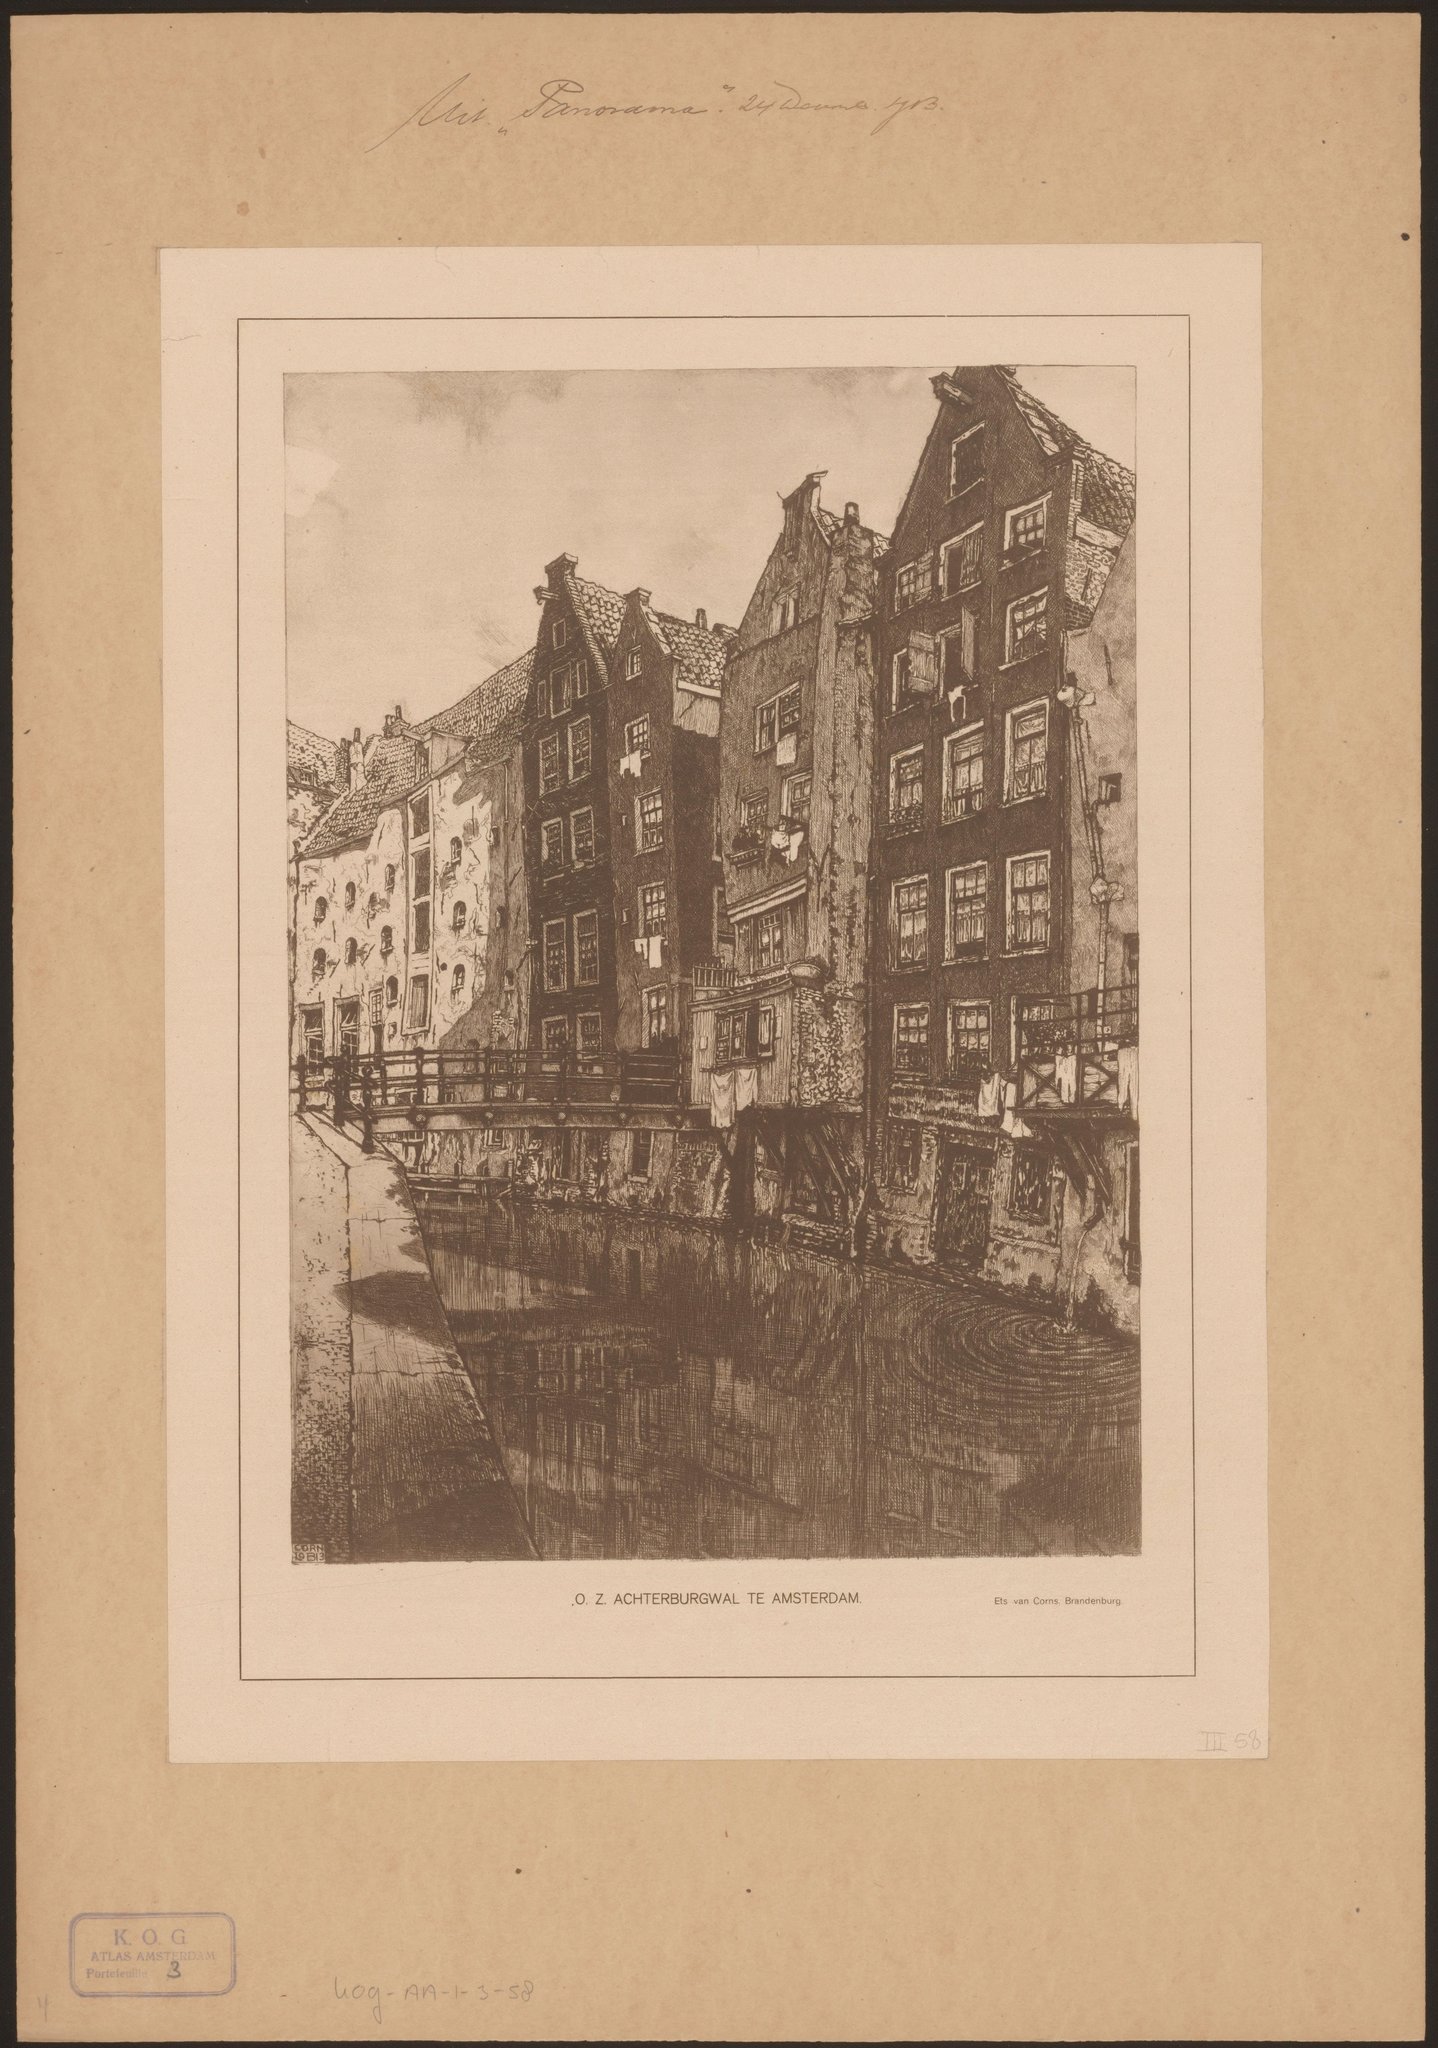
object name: photomechanical print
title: Gezicht op de Oudezijds Achterburgwal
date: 1913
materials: paper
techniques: letterpress printing, rotogravure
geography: amsterdam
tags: city-view in general; 'veduta', canal, the usual house or row of houses, bridge in city across river, canal, etc.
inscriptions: collector's mark: ‘3’ Lugt 1641b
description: Onderwerpsrubriek binnen de Atlas Amsterdam: Achterburgwal, Nieuwezijds en - Oudezijds; Nieuwe Achtergracht, Achterweg, Akoleienstraat.